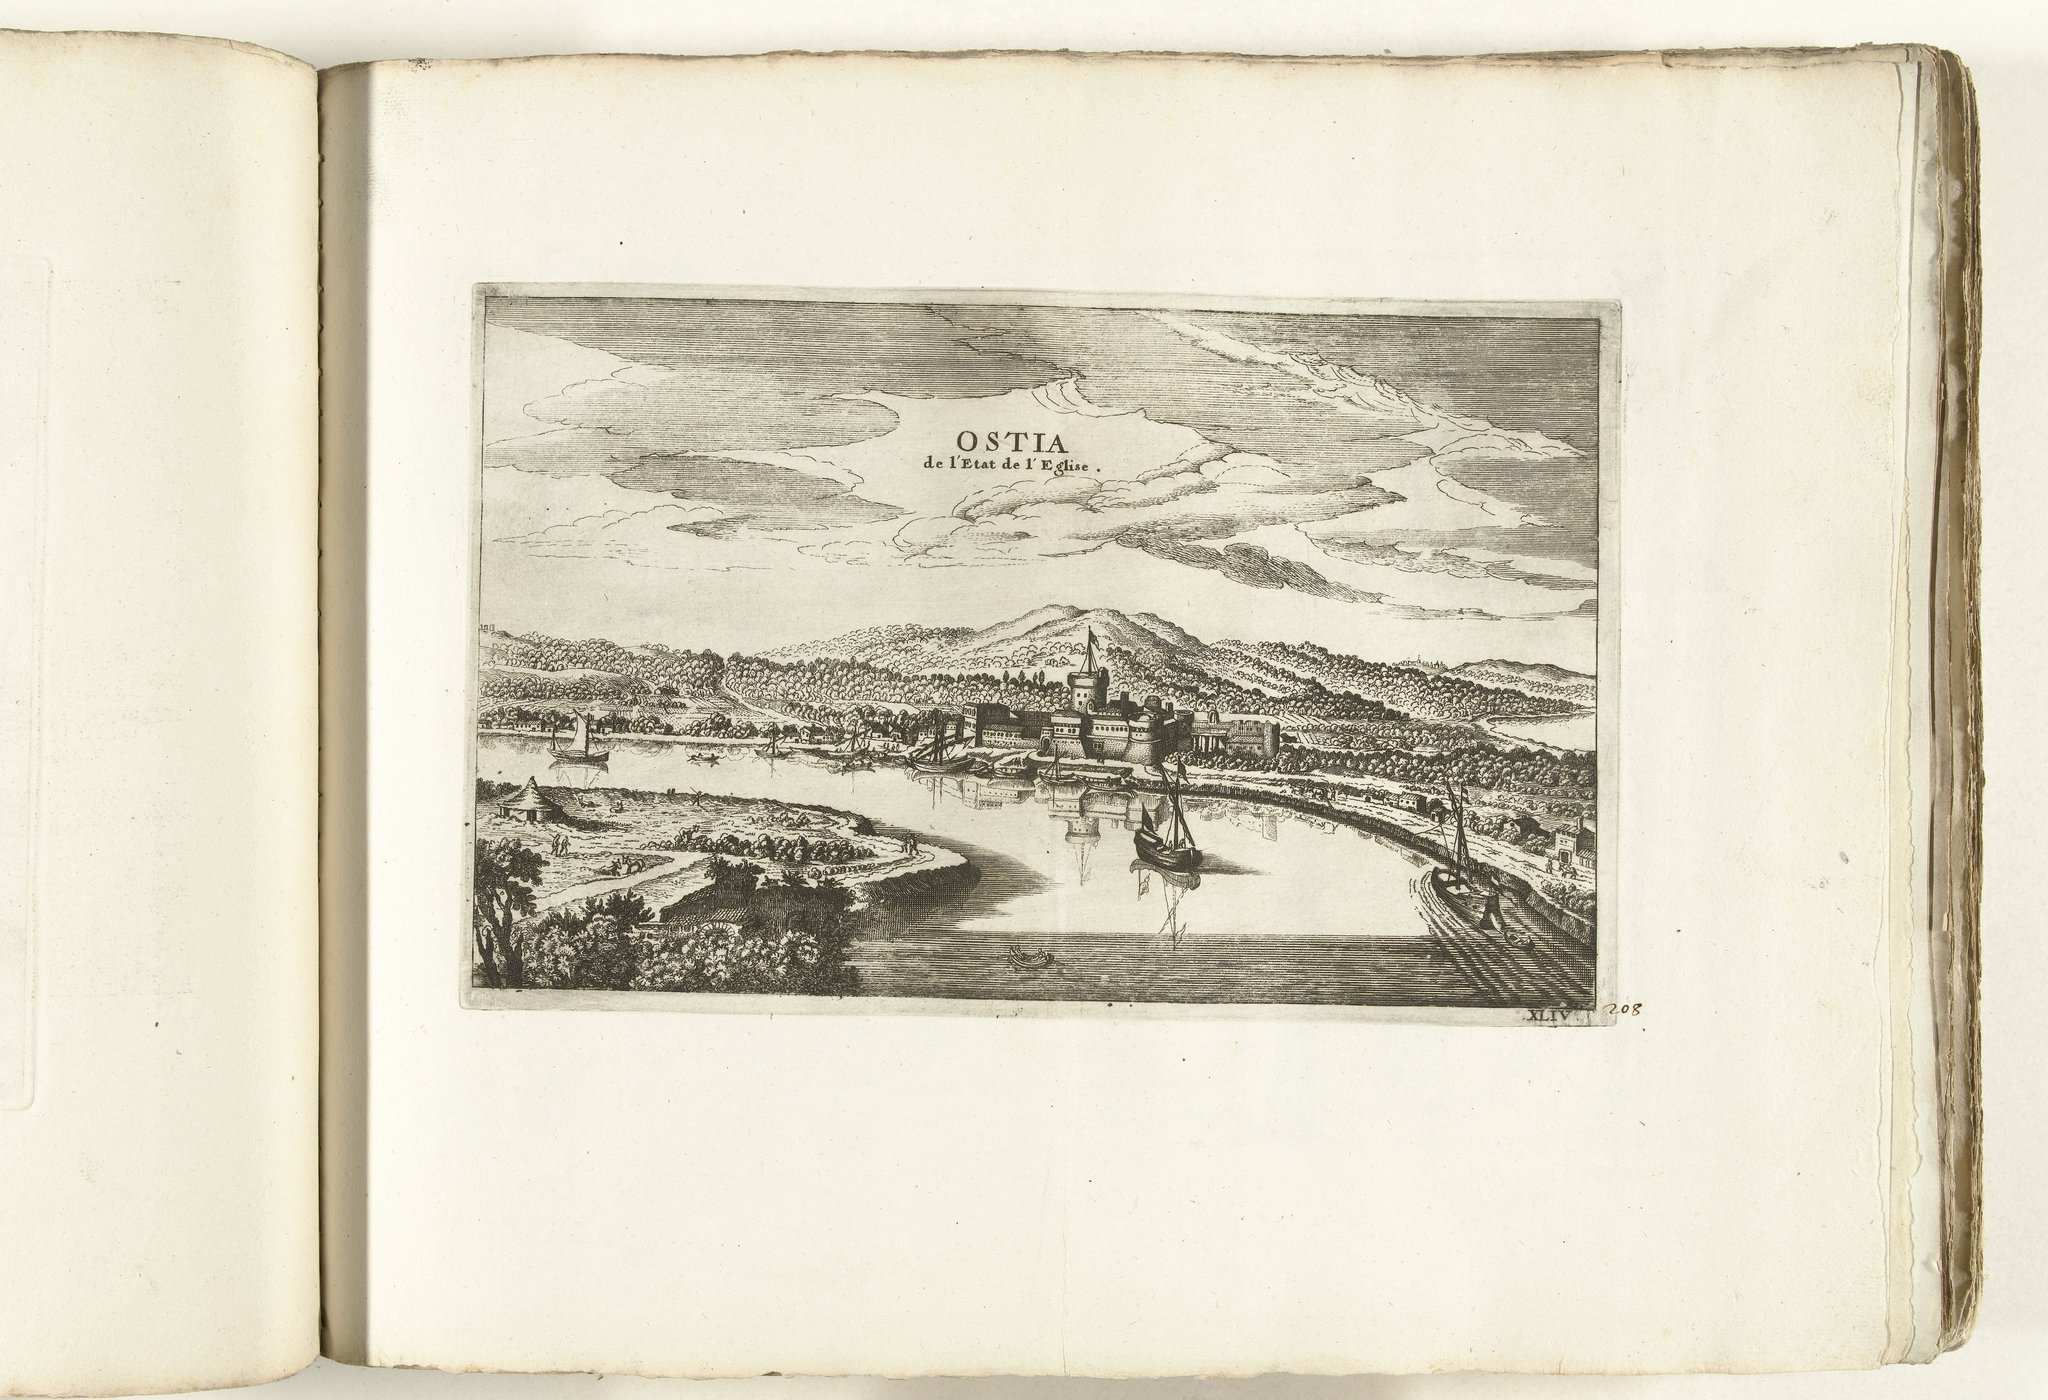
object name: print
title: Ostia de l'Etat de l'Eglise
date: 1702-1703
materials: paper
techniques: etching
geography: northern netherlands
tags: ostia, spaanse successieoorlog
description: Gezicht op de Italiaanse stad Ostia. Gemerkt rechtsonder: XLIV. Plaat nr. 208 in het prentwerk bestaande in totaal uit 276 genummerde platen van vermaarde sterke steden en vestingen in het kader van de Spaanse Successieoorlog. Voor het merendeel zijn deze platen gekopieerd naar de anonieme Franse platen: in Les forces de l'Europe en in: Le theatre de la guerre, dans les Pays-Bas, beide oorspronkelijk uitgegeven door Nicolas de Fer te Parijs (1693-1697) in het kader van de Negenjarige Oorlog. Titel en opschriften in de plaat in het Frans.